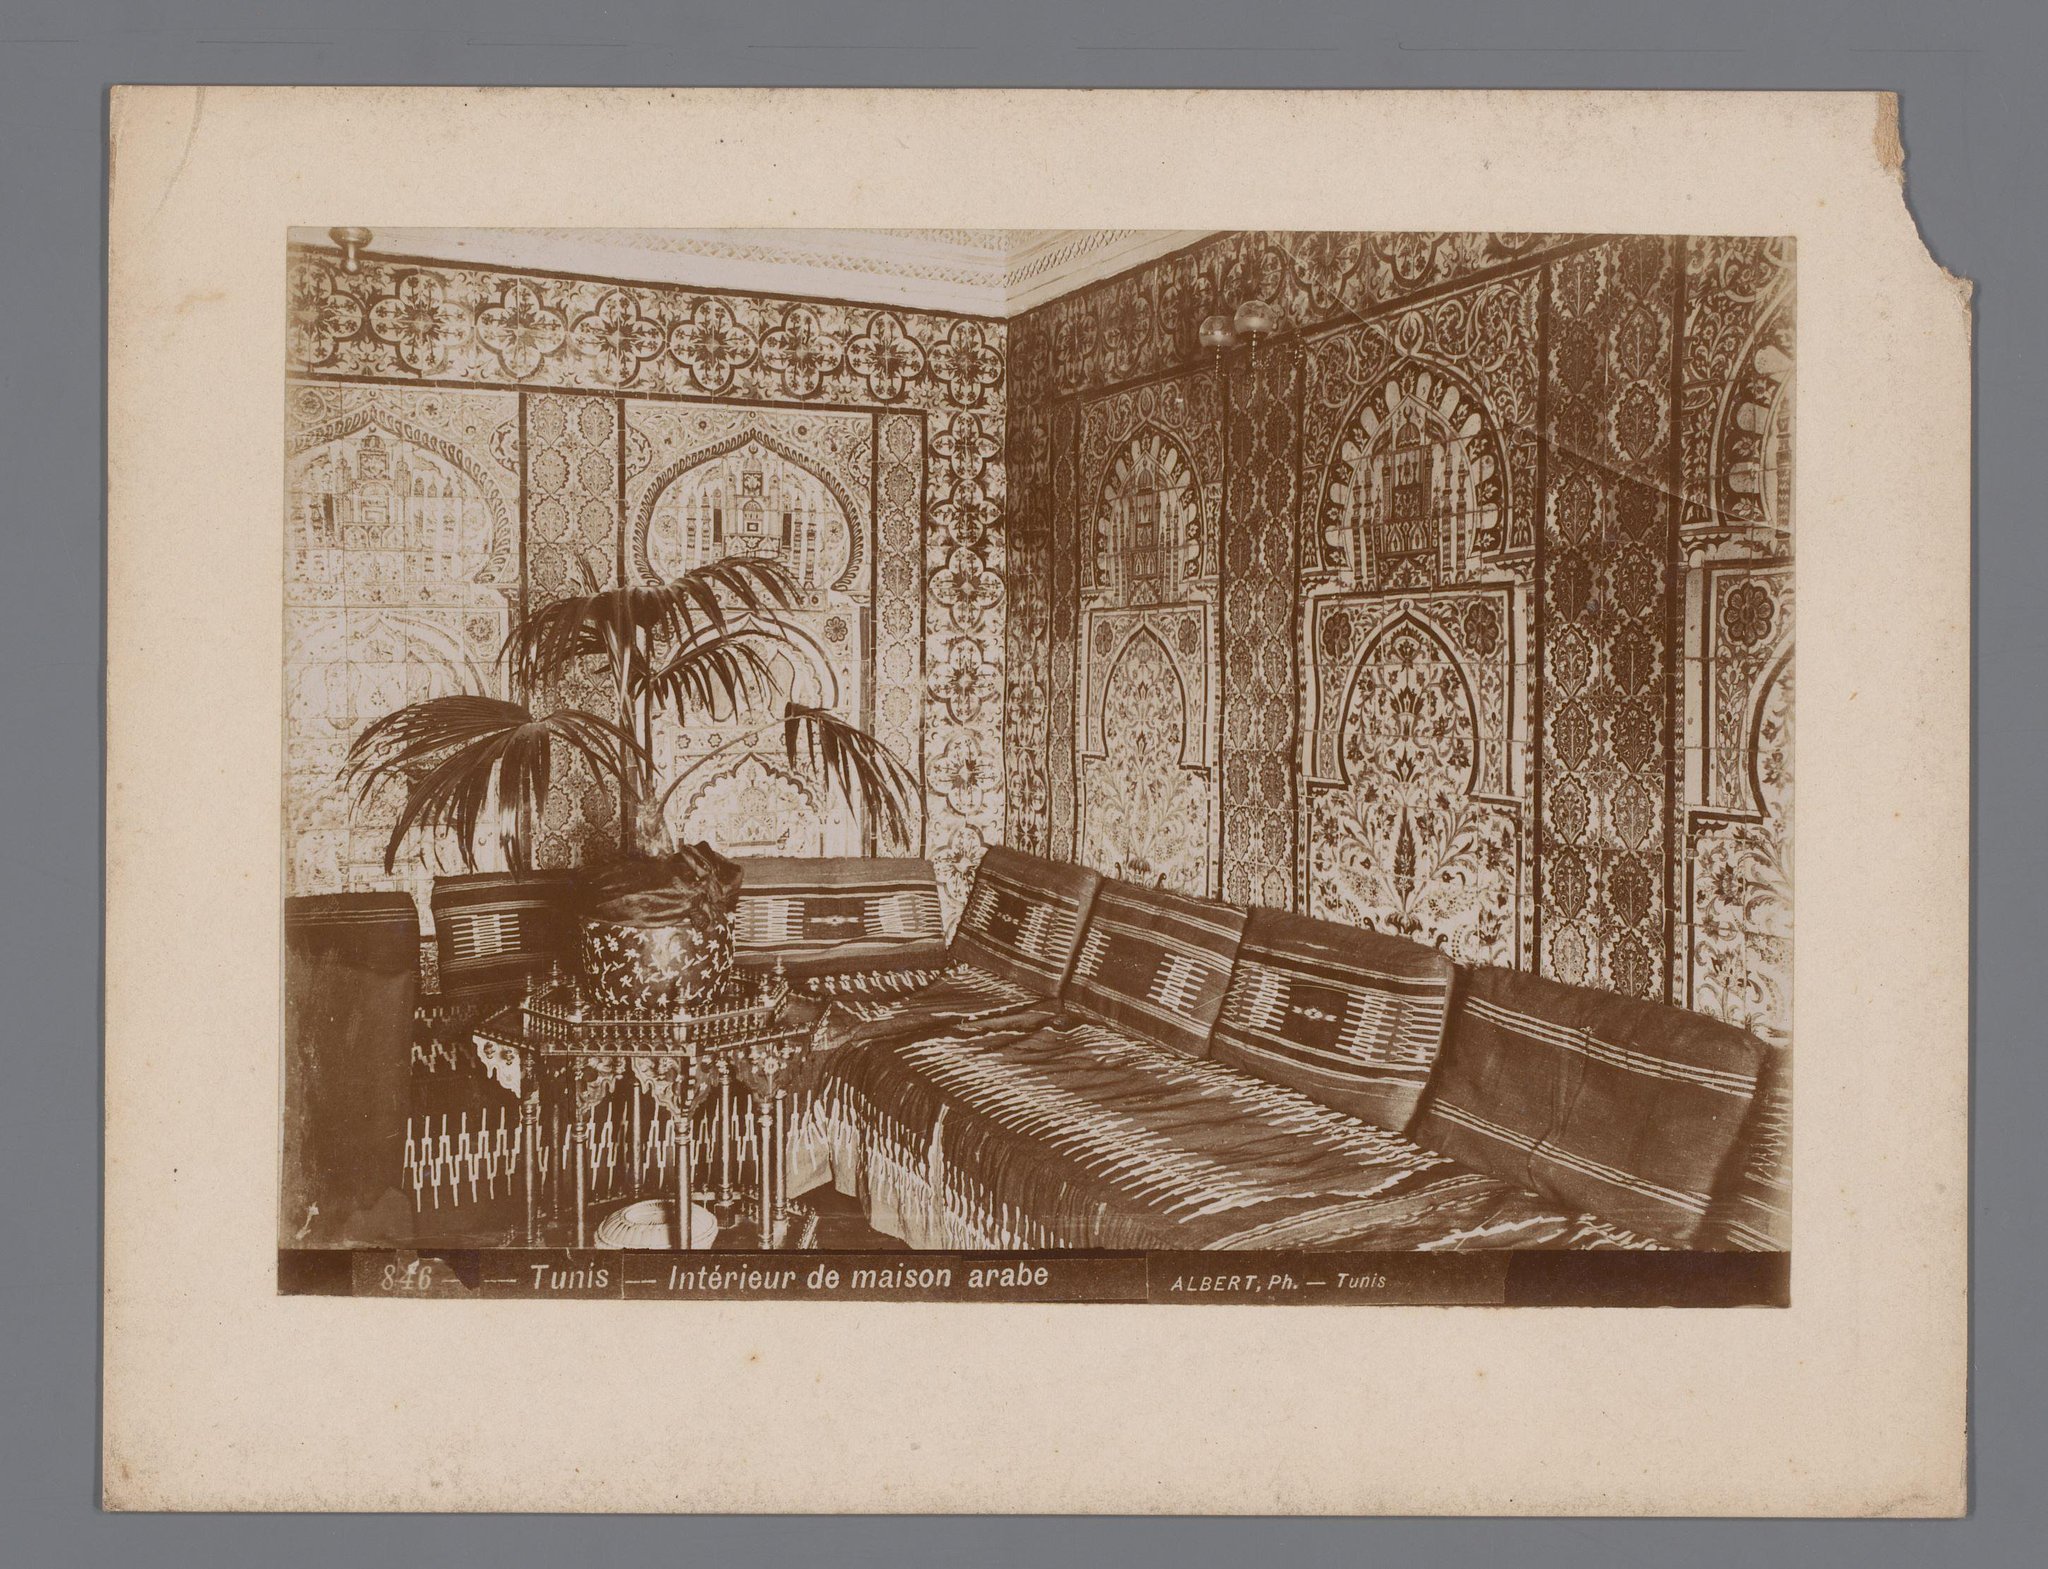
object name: photograph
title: Tunis, intérieur de maison Arabe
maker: albert goupil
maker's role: publisher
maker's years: 1840-1884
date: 1860-1900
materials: cardboard, paper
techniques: albumen print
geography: tunis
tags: civic architecture; edifices; dwellings - aa - civic architecture: inside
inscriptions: number: ‘846’